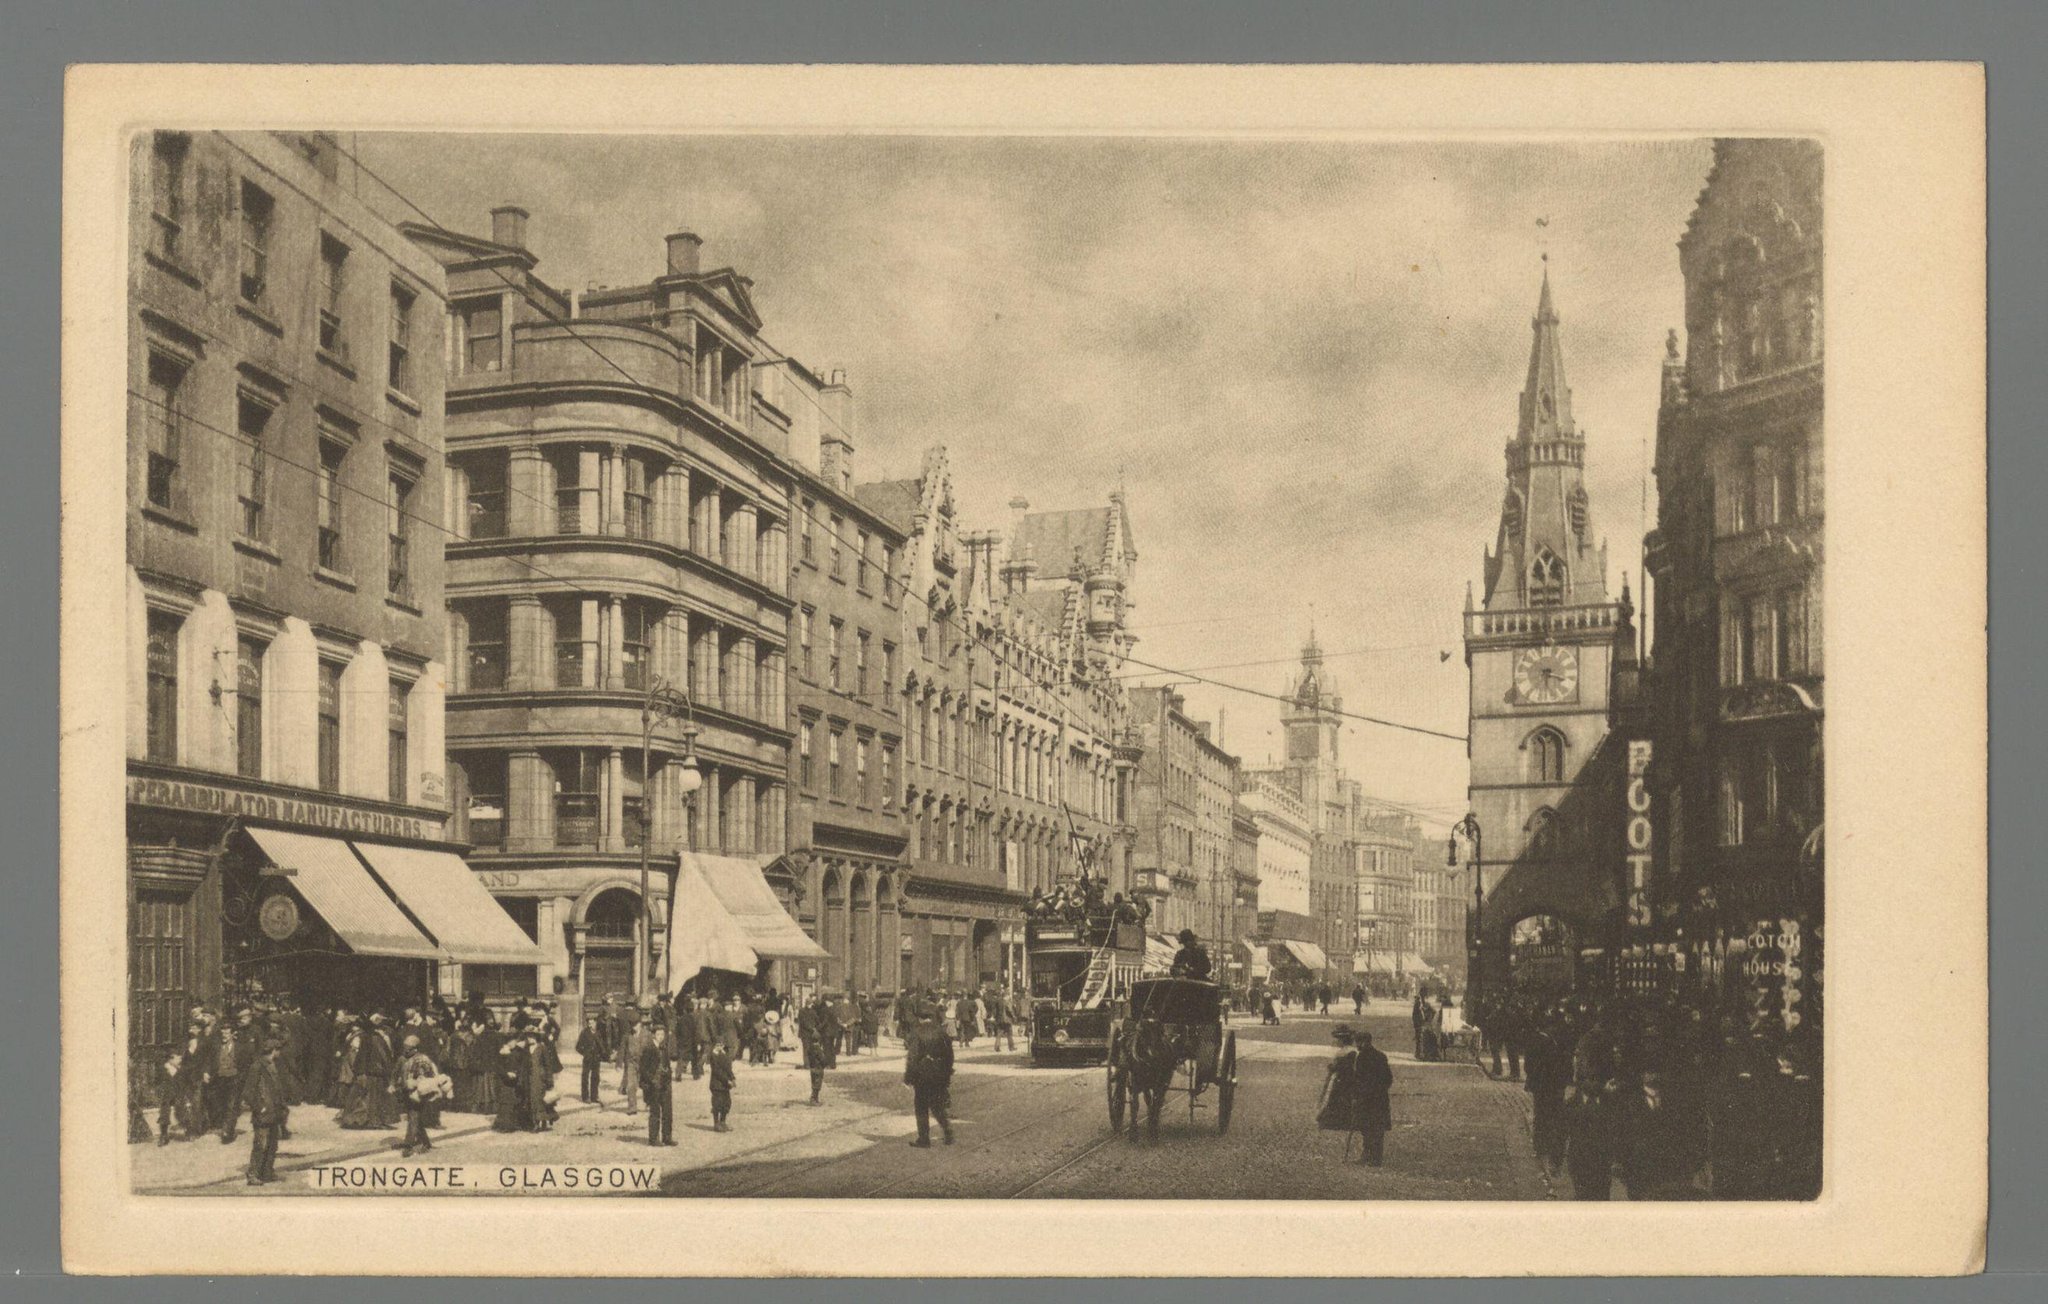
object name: ansichtkaart, prentbriefkaart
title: Trongate. Glasgow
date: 1894-1905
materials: cardboard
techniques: photoaquatint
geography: glasgow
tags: street, city-gate